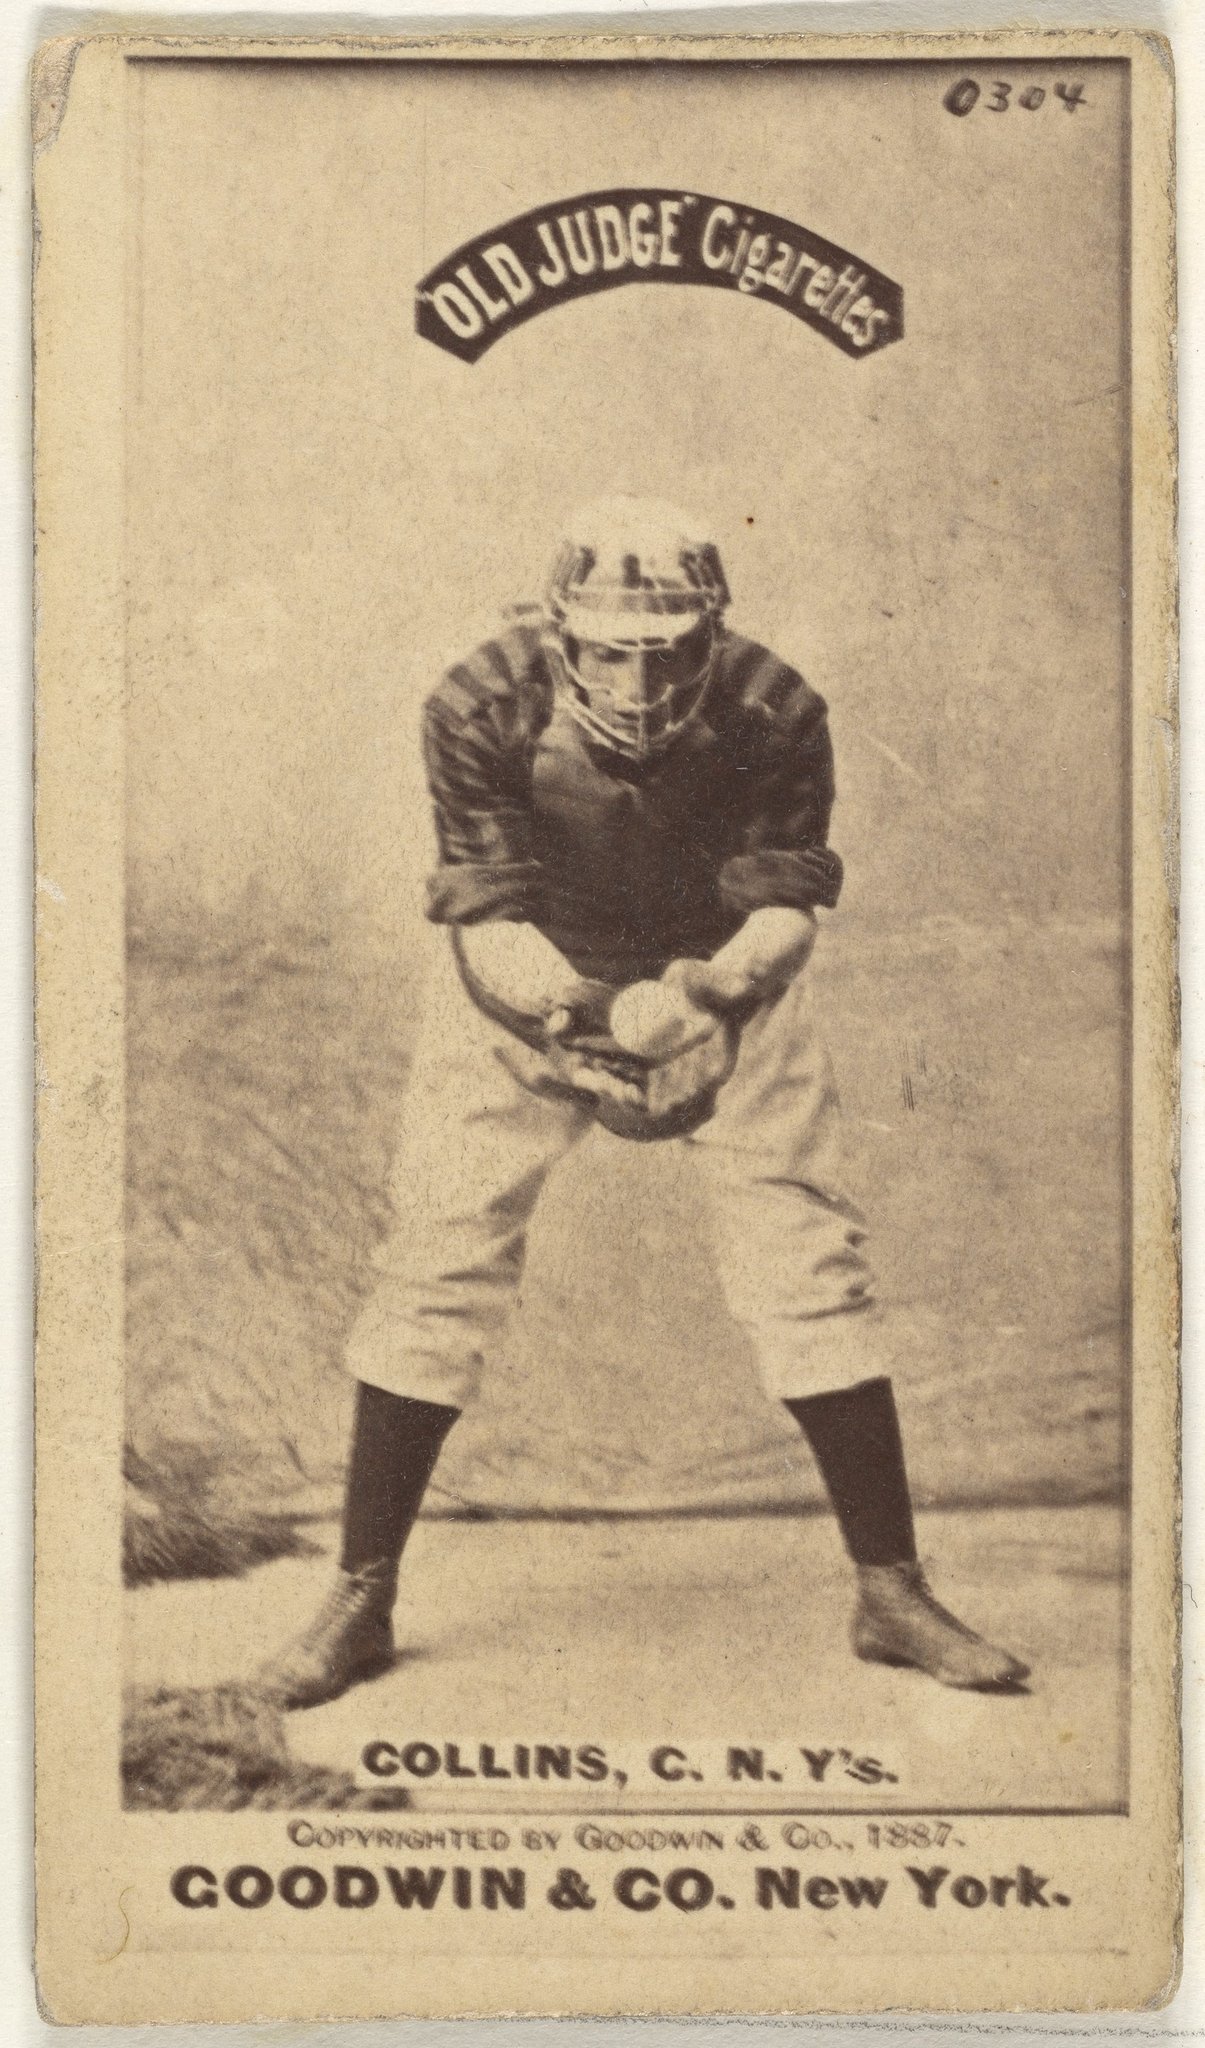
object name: baseball card, photograph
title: Bill Collins, Catcher, New York, from the Old Judge series (N172) for Old Judge Cigarettes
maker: goodwin & company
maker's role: publisher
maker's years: 1850-1950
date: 1887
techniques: albumen silver print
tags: men,portraits,baseball,athletes